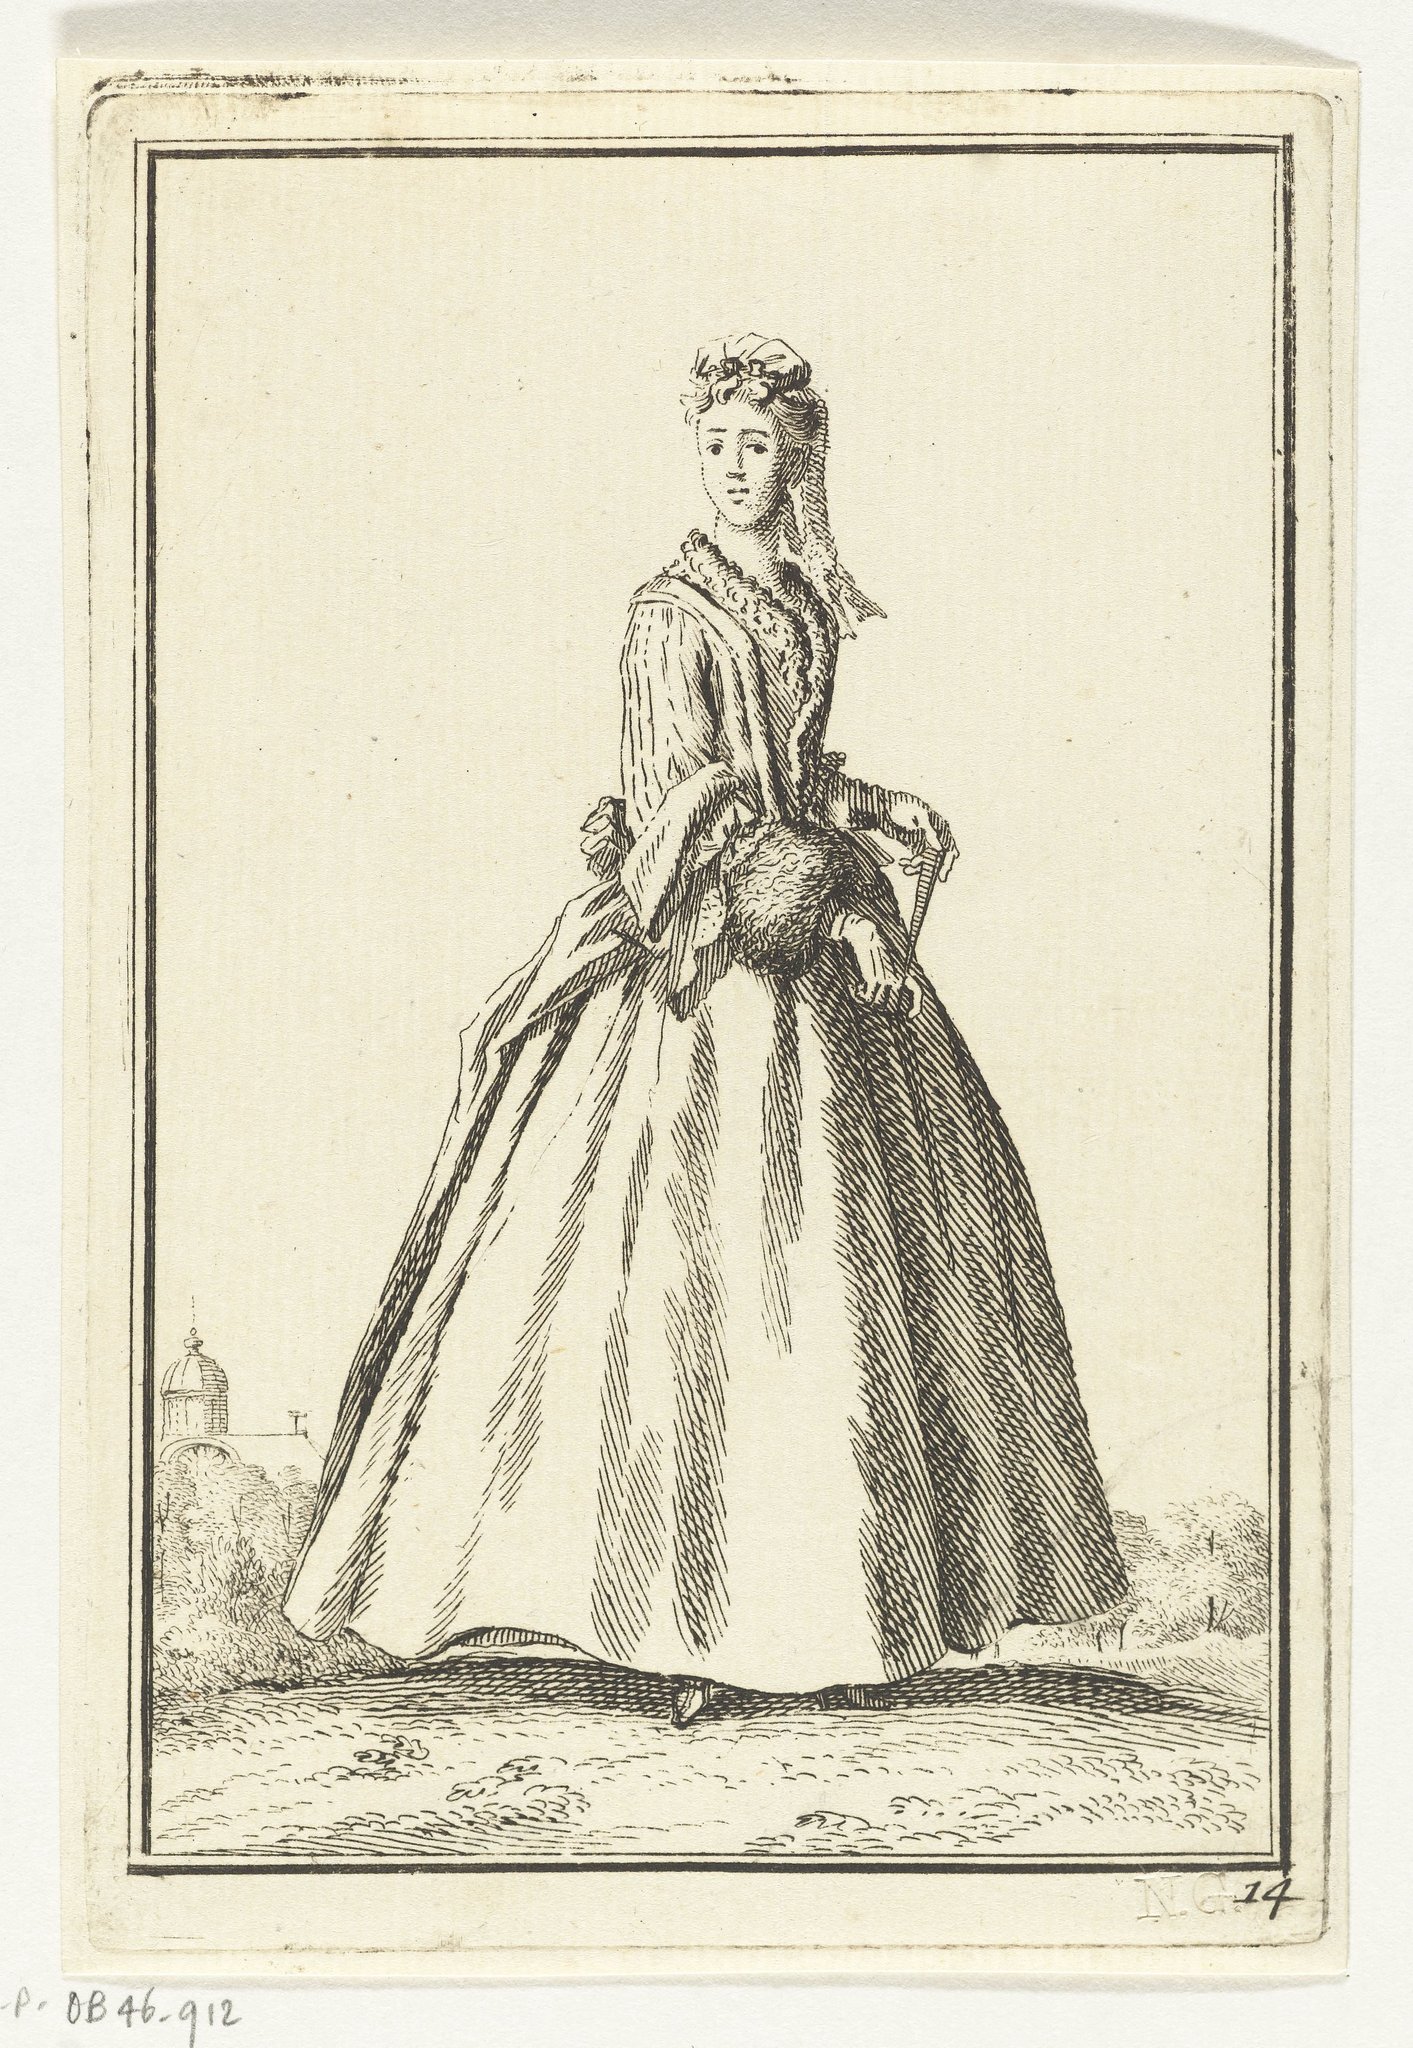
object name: costume print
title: Hollandse kostuums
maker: adolf van der laan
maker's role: draughtsman, print maker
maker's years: 1689-1742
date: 1710-1755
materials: paper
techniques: etching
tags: europeans (with name) (+ costume), dress, gown (+ women's clothes), fan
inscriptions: collector's mark: Lugt 2228, collector's mark: Lugt 1967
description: Vrouw in een landschap, gekleed volgens de Hollandse mode van 1710-1720. Ten voeten uit, naar rechts gekeerd. Mutsje op het hoofd en een gesloten waaier in de hand. De prent maakt deel uit van een zestiendelige serie prenten met voorstellingen van Hollandse kostuums.